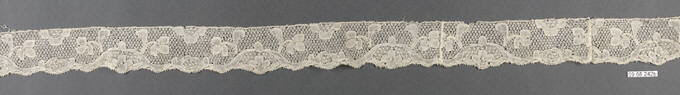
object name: strip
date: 1701-1733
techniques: lace